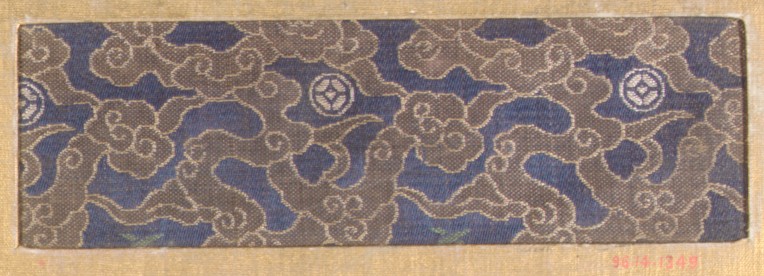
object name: piece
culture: japanese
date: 1701-1900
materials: silk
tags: clouds